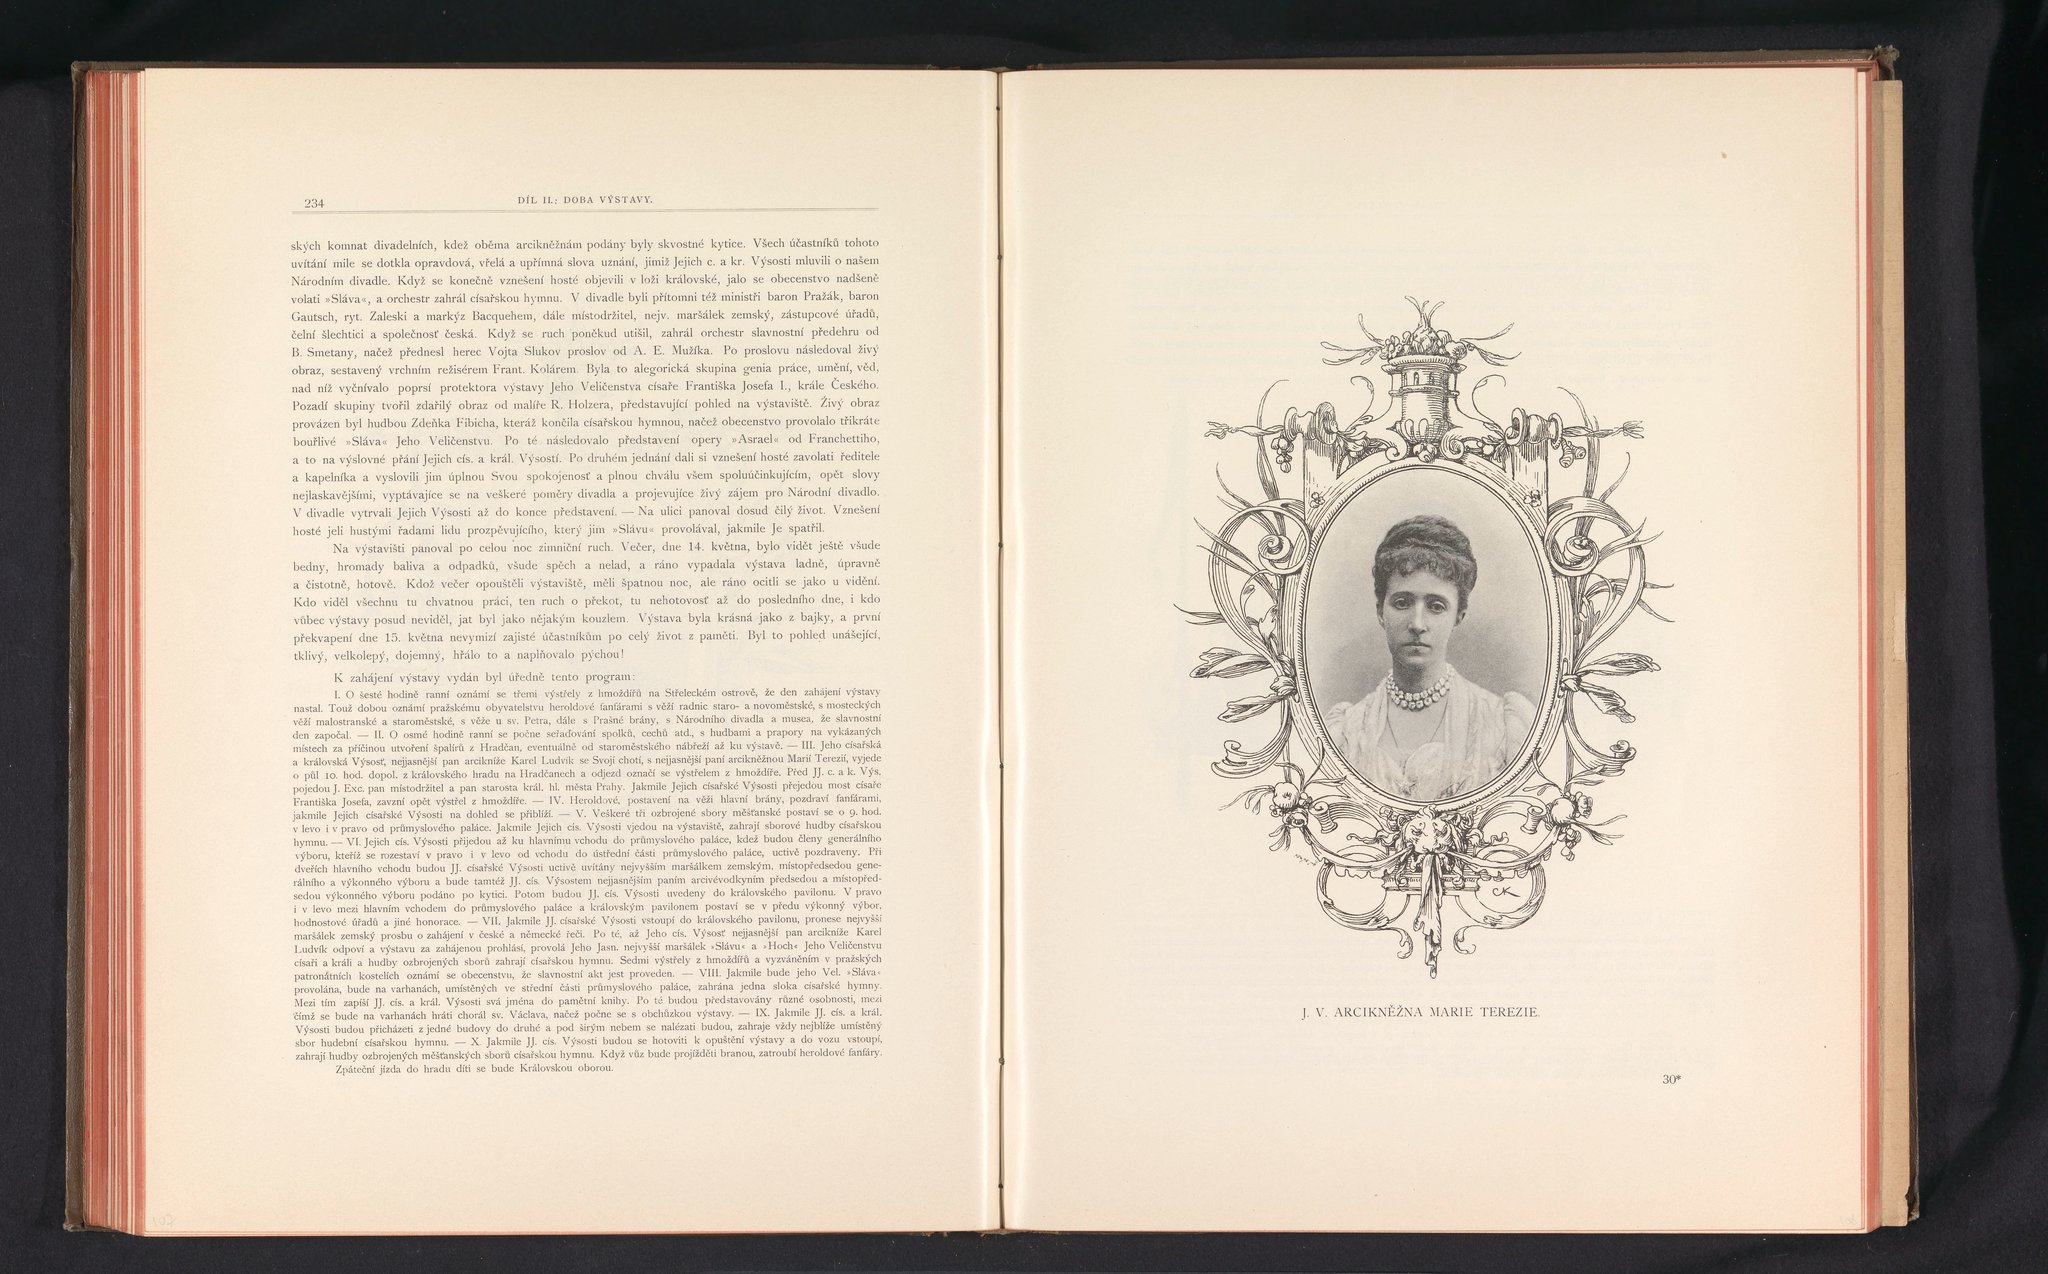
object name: page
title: J.V. Arciknezna Marie Terezie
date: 1888-1893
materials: paper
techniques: autotype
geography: prague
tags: ruler, sovereign - bb - female ruler